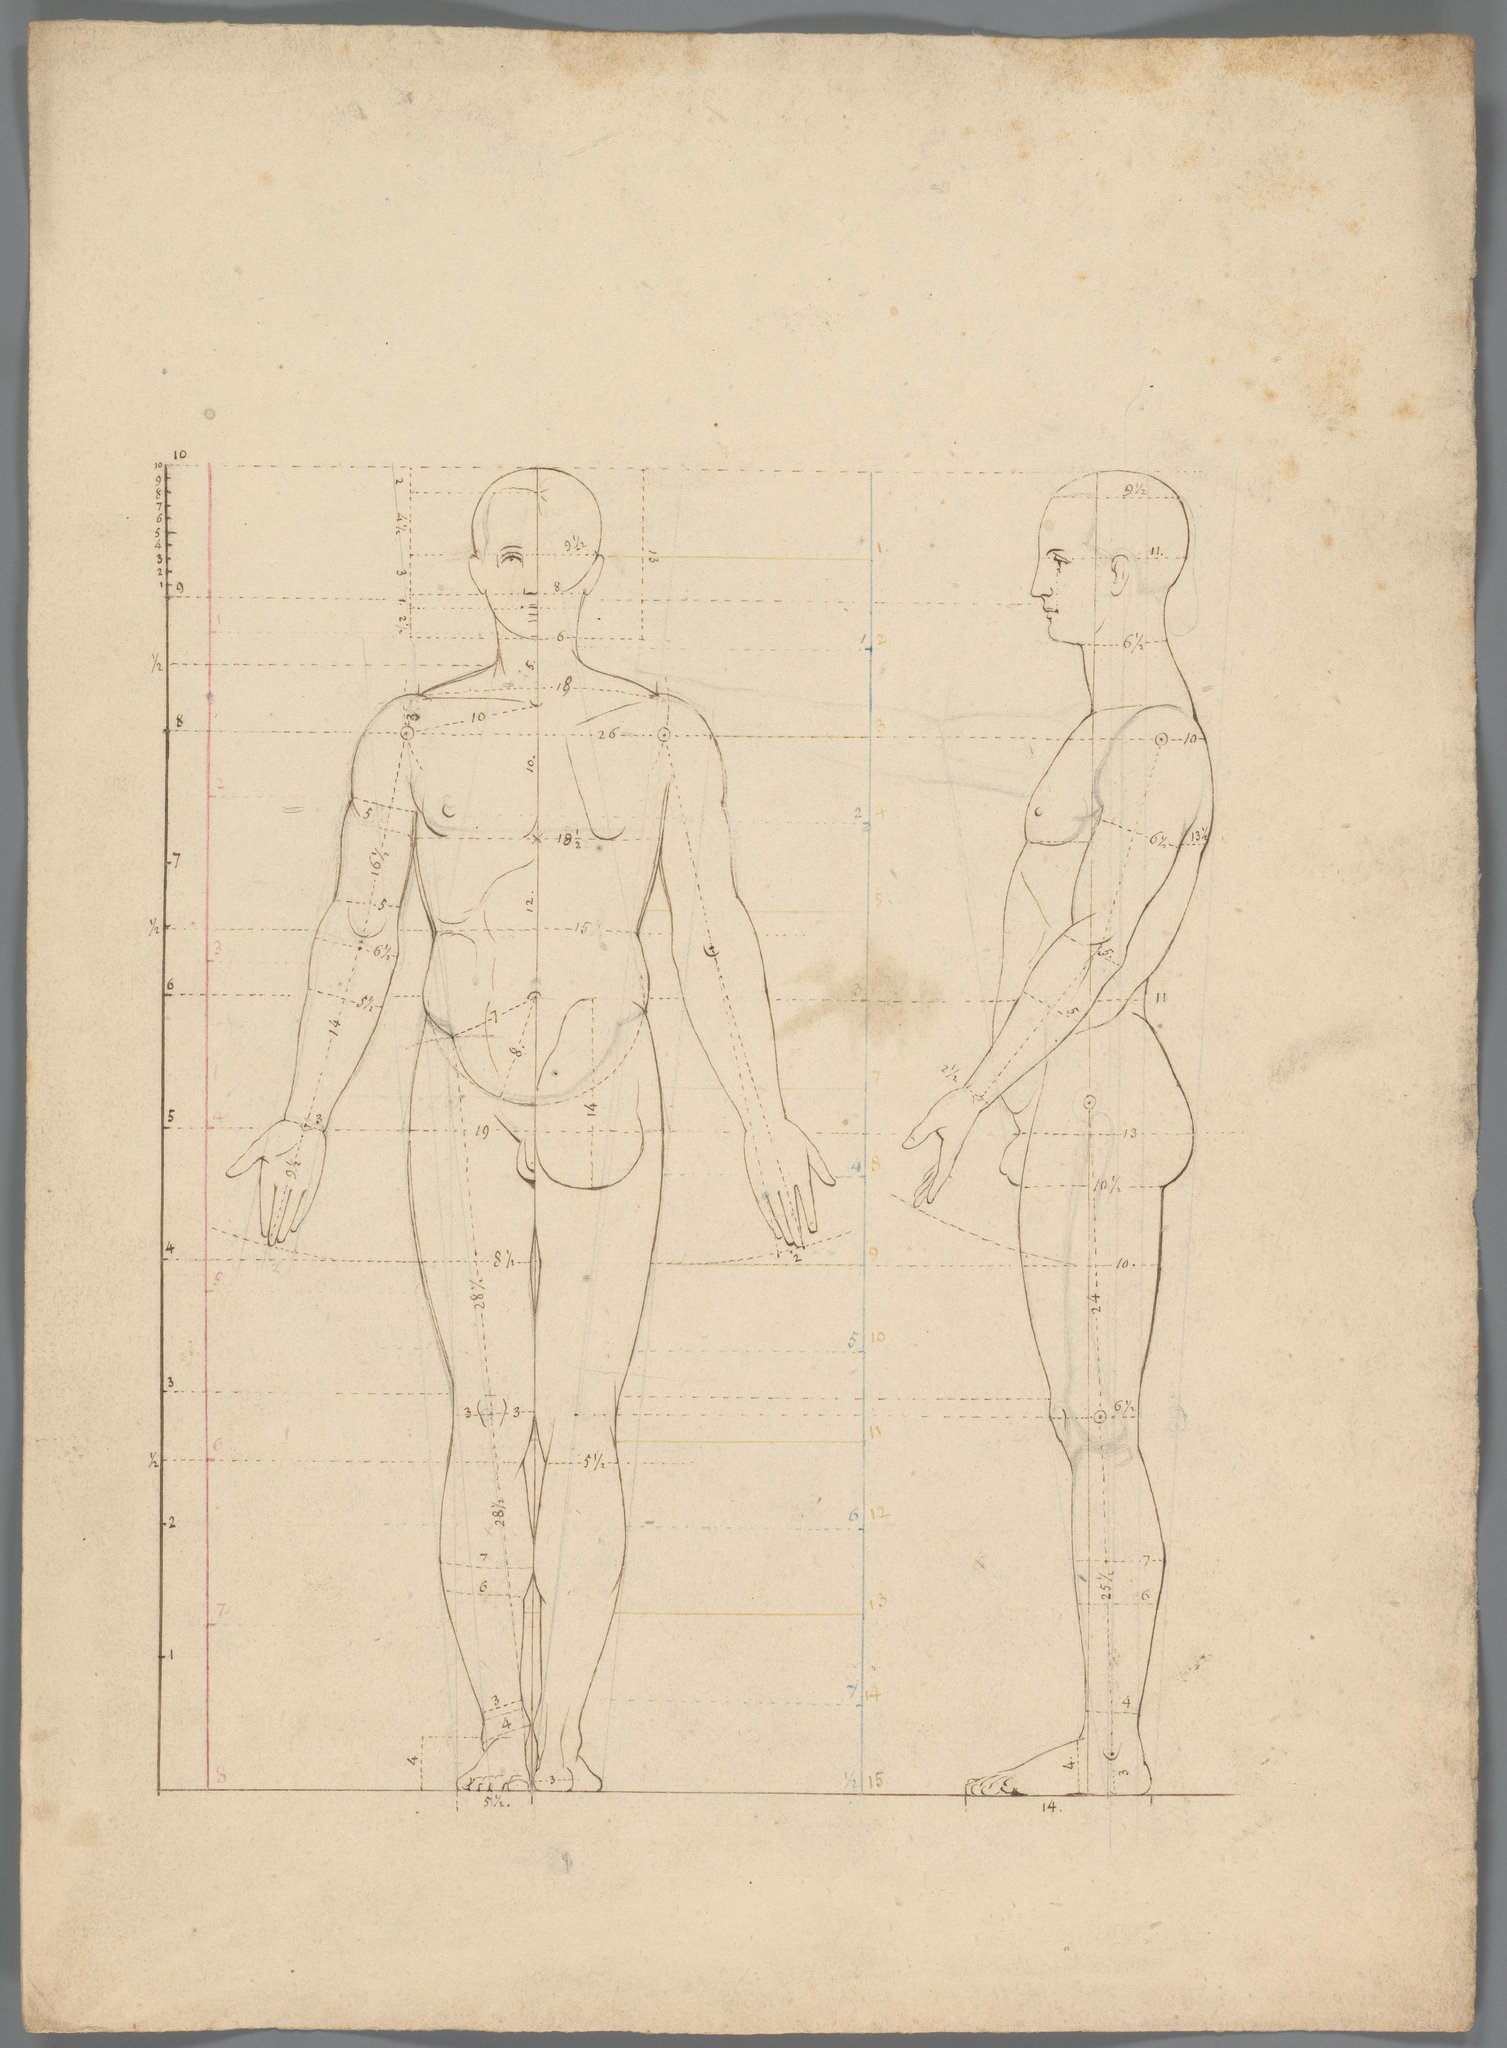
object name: drawing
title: Proportiestudie van een man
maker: jacobus everhardus josephus van den berg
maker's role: draughtsman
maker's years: 1802-1861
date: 1812-1861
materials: ink, paper, pencil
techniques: pen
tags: human figure of ideal proportions, e.g. academic nude